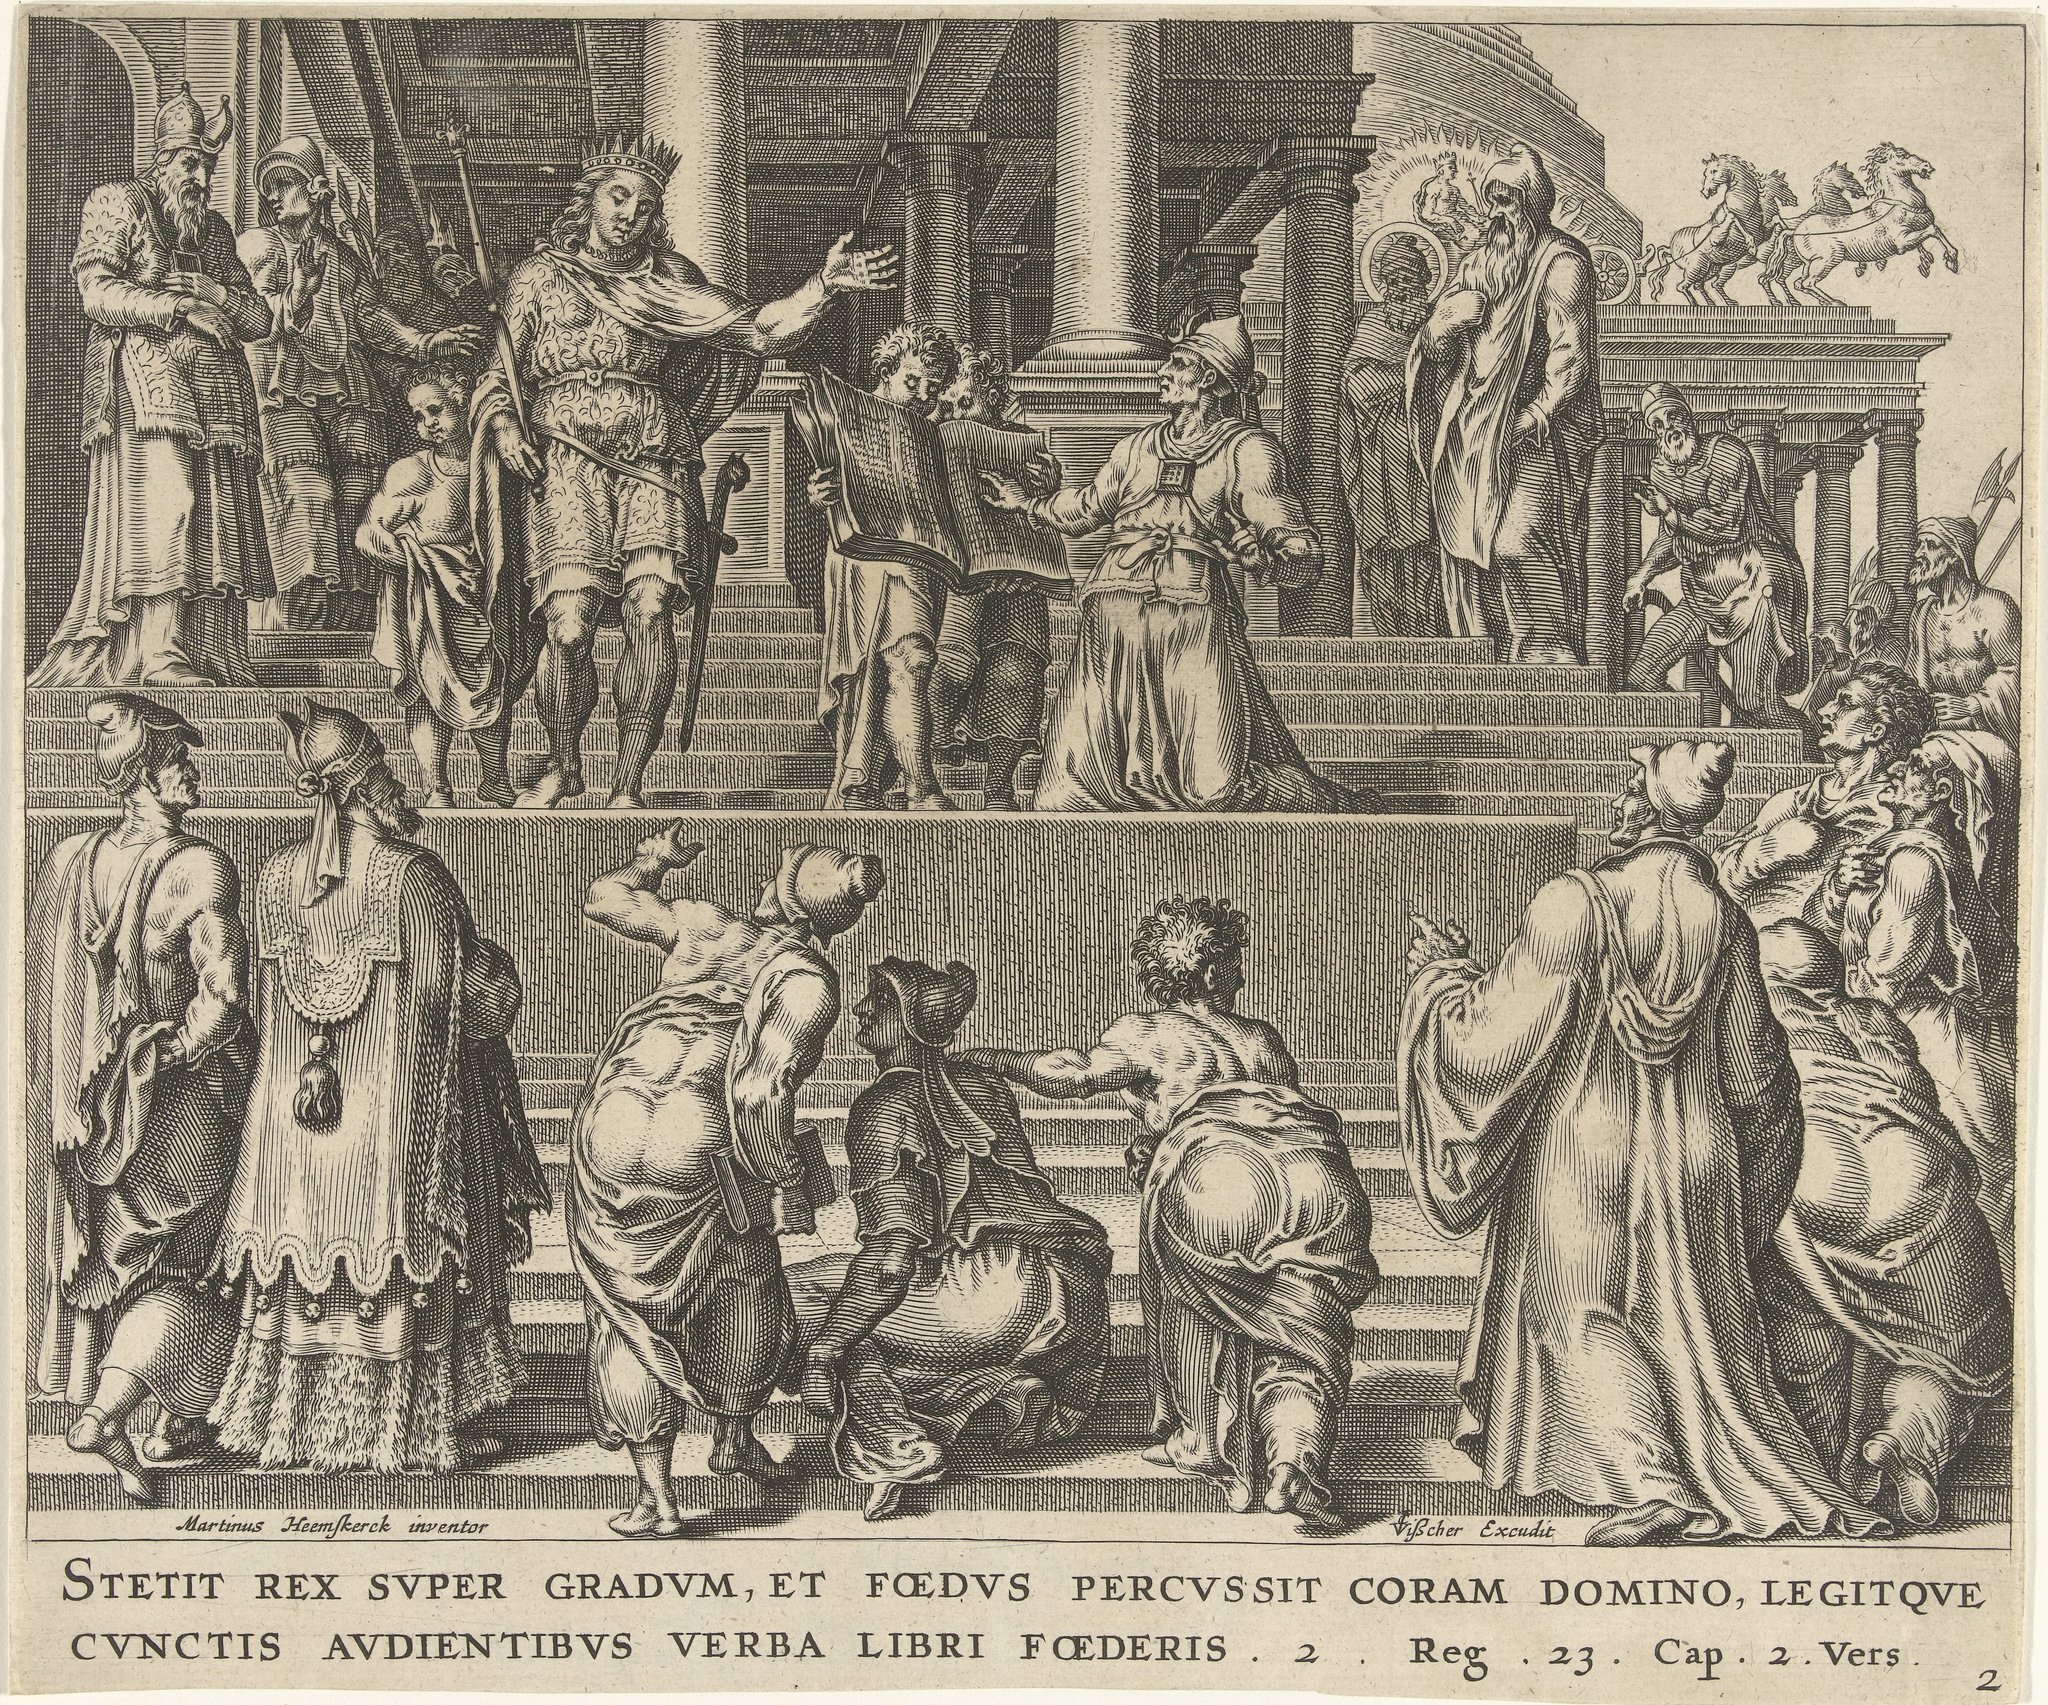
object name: print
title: Geschiedenis van koning Josia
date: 1600-1652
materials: paper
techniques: engraving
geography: amsterdam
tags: before the assembled people king josiah reads the book of law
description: Koning Josia staat op de trappen van de tempel en laat het teruggevonden wetboek van God voorlezen aan het volk van Israel. Josia maakt een uitnodigend handgebaar en zweert om Gods wetten te volgen.